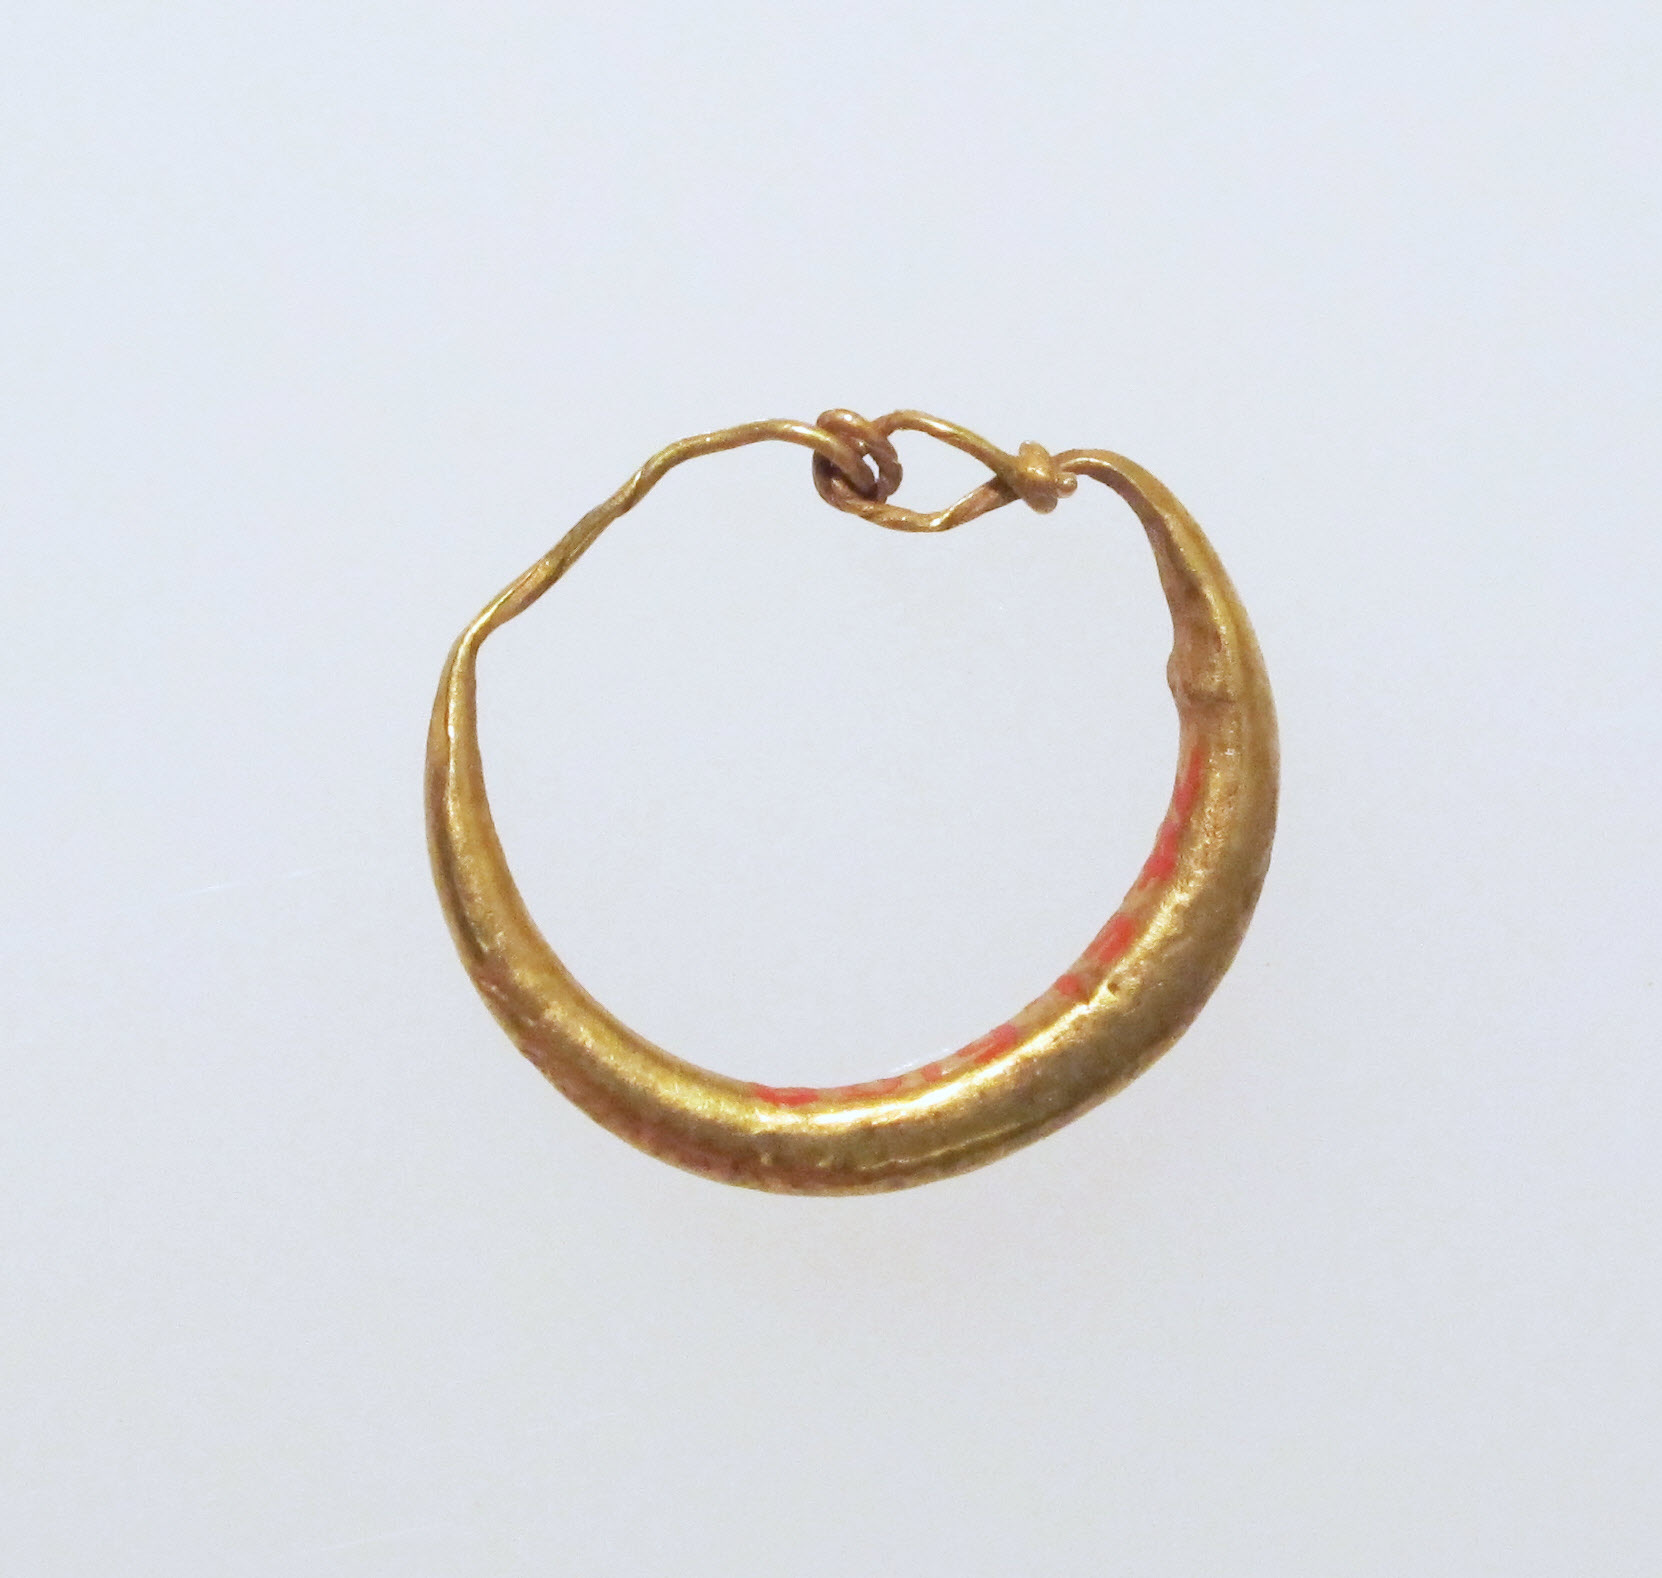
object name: earring loop type, plain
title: Earring-loop type, plain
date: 7000 BCE-330 CE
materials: gold